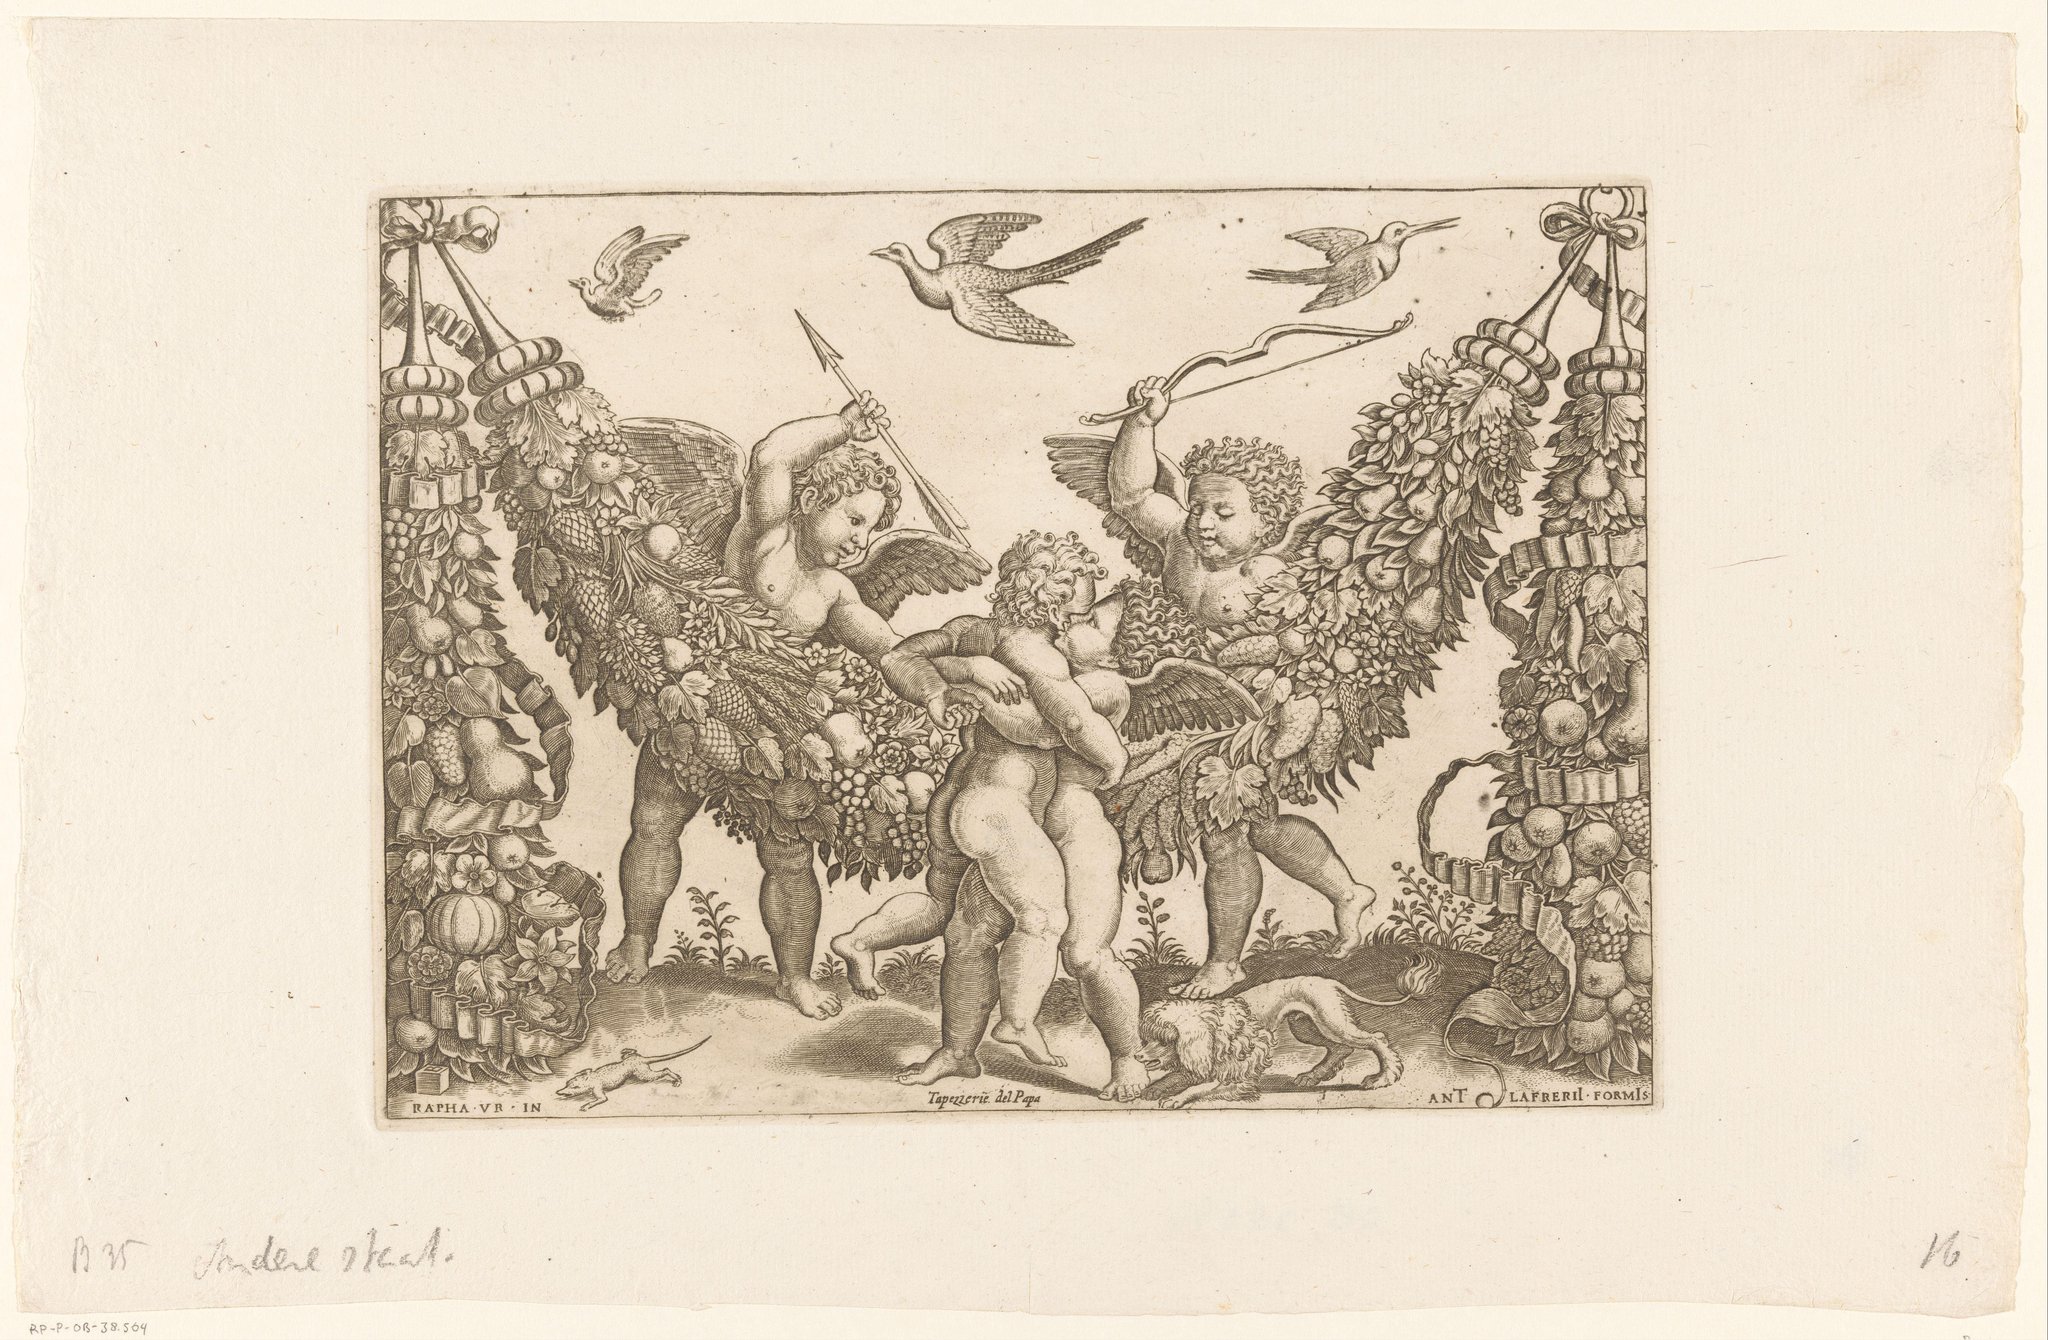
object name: print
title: Tapisserieën van de paus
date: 1530-1560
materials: paper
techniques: engraving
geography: italy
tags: cupids: 'amores', 'amoretti', 'putti', dog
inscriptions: collector's mark: Lugt 2228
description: Voor een grote guirlande tilt een putto een kind op. Achter de guirlande twee putti met pijl-en-boog. In de lucht drie vogels en op de voorgrond een hond.